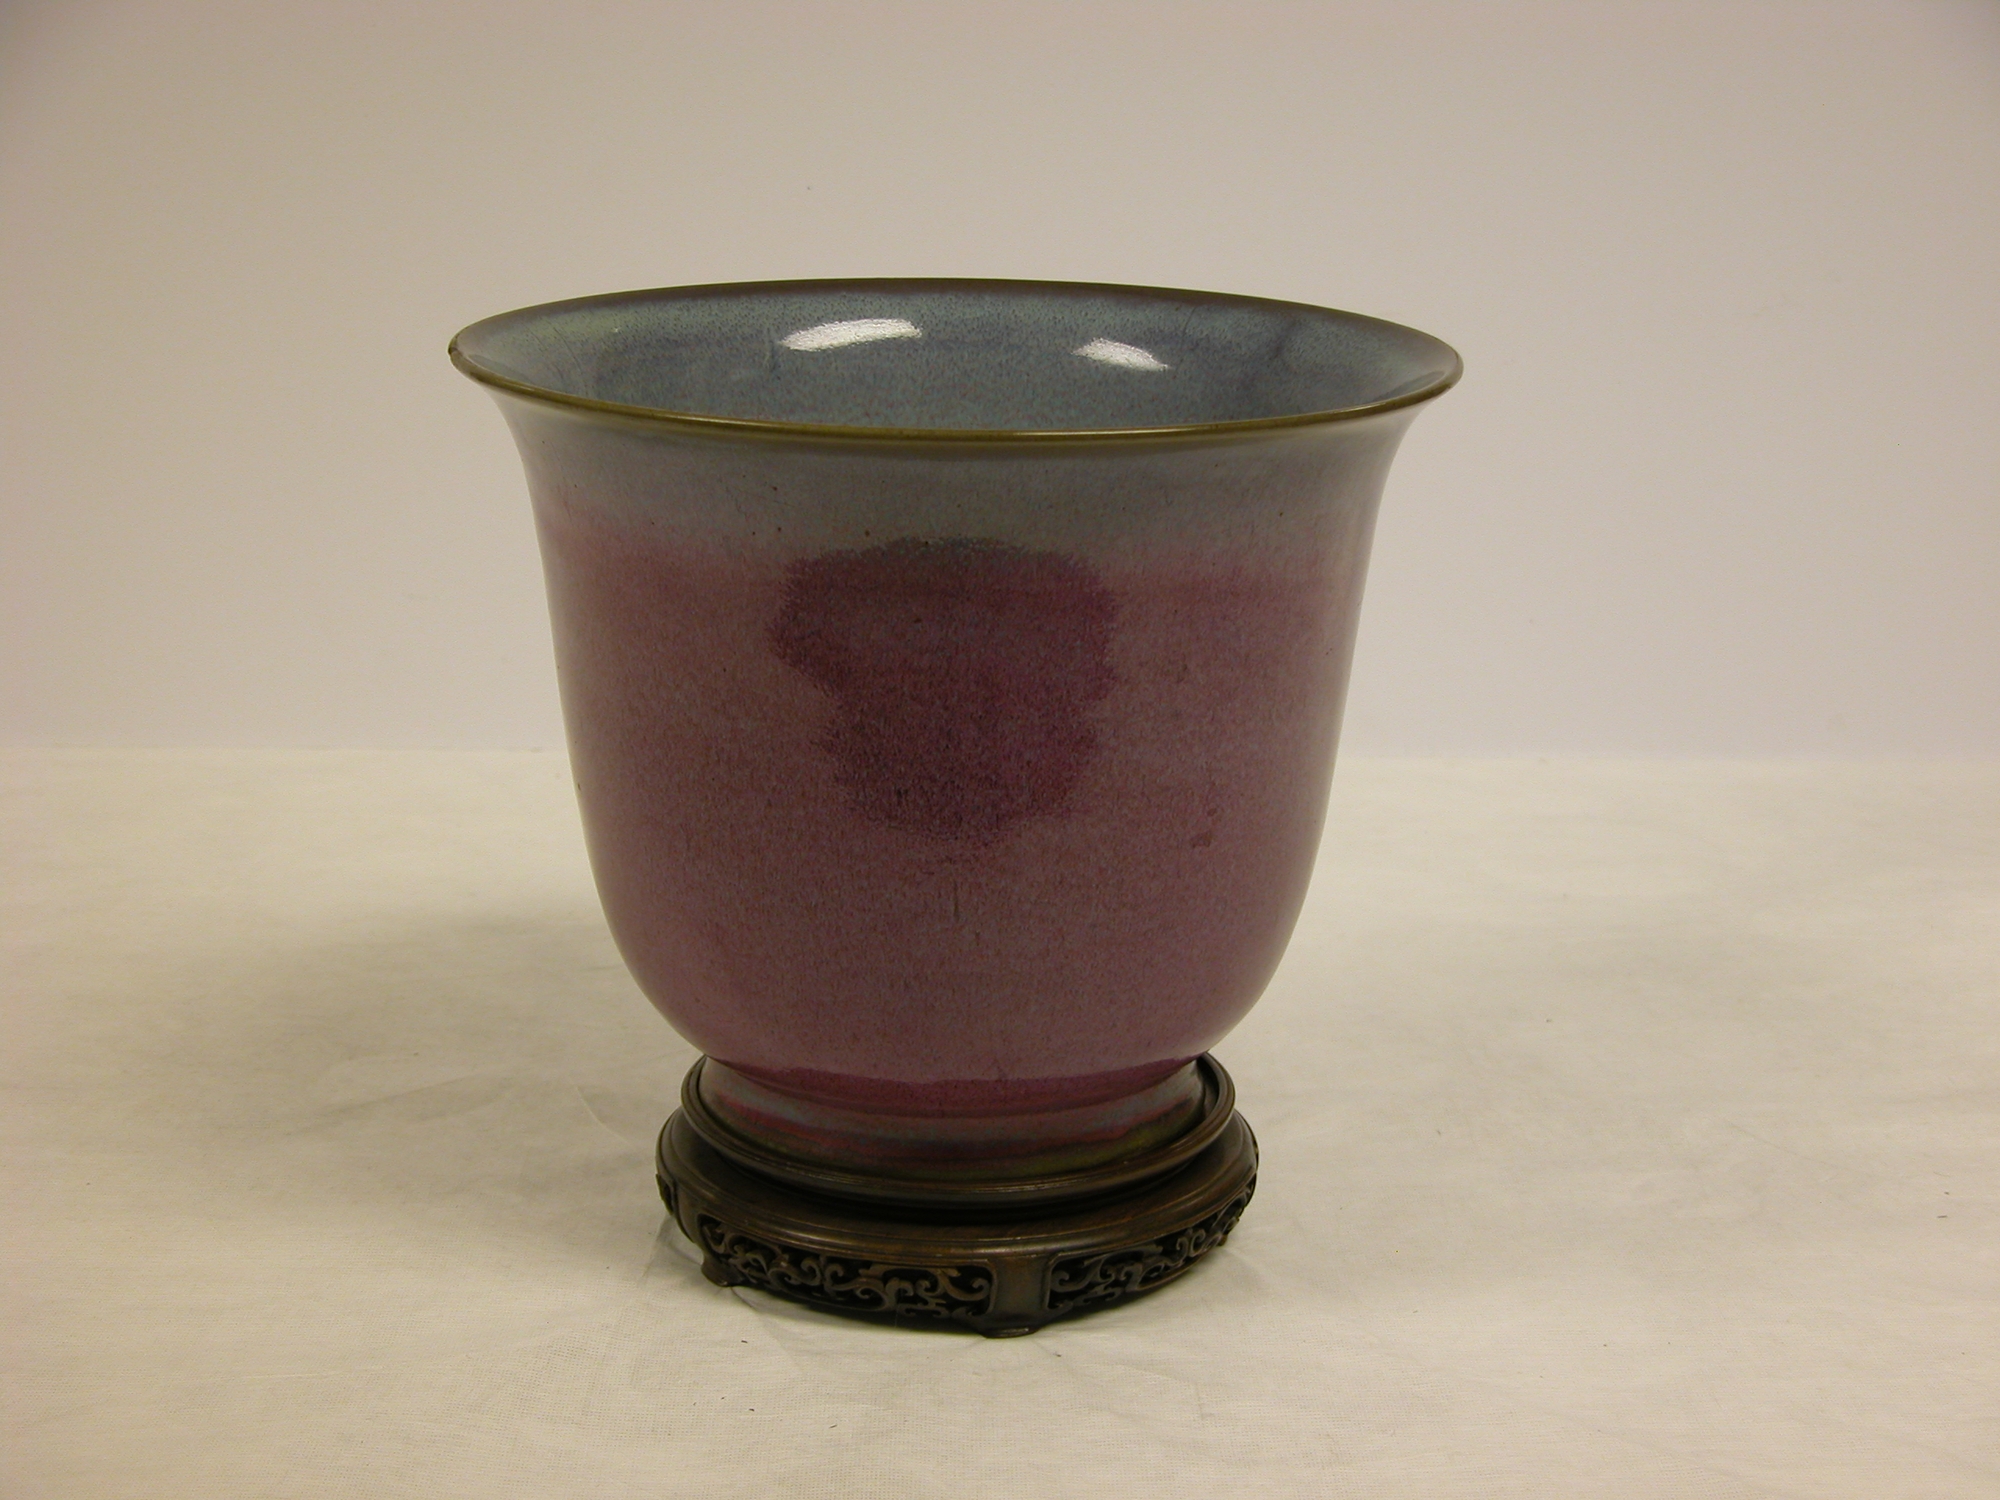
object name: flowerpot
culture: chinese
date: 1401-1500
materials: glaze, stoneware